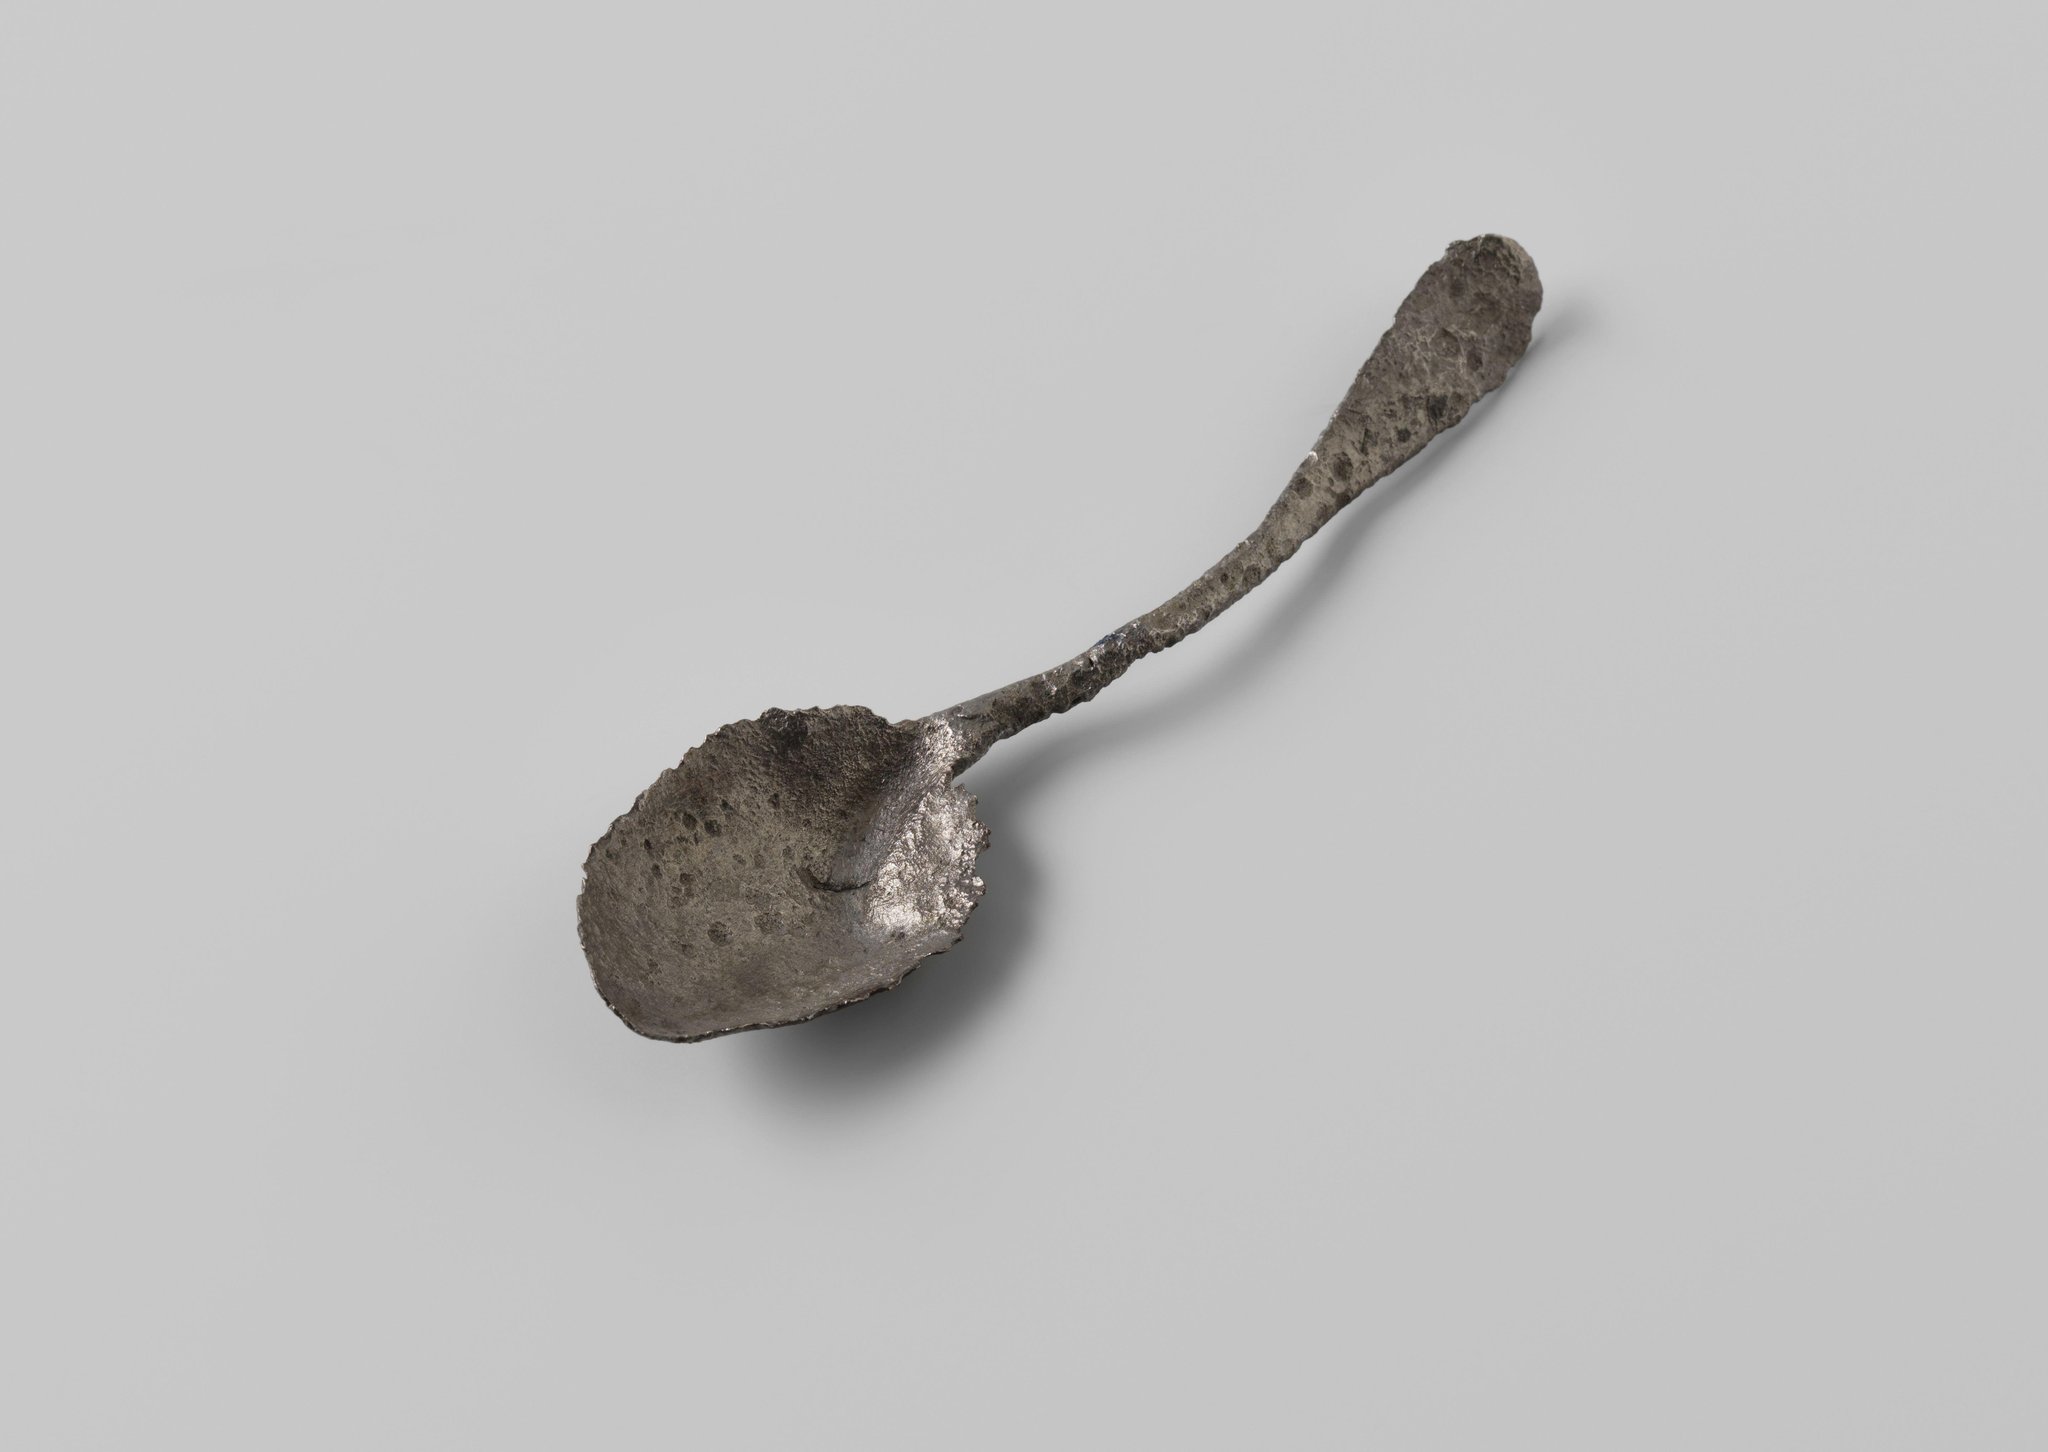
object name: spoon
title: Pewter spoon from the wreck of the Dutch East Indiaman Hollandia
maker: Anonymous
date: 1700-1743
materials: tin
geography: netherlands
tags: verenigde oostindische compagnie, hollandia (schip), annet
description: Cutlery, spoon; heavily corroded, bowl id. NG 1980-27H1165, stem id. NG 1980-27H527, inscription illegible.